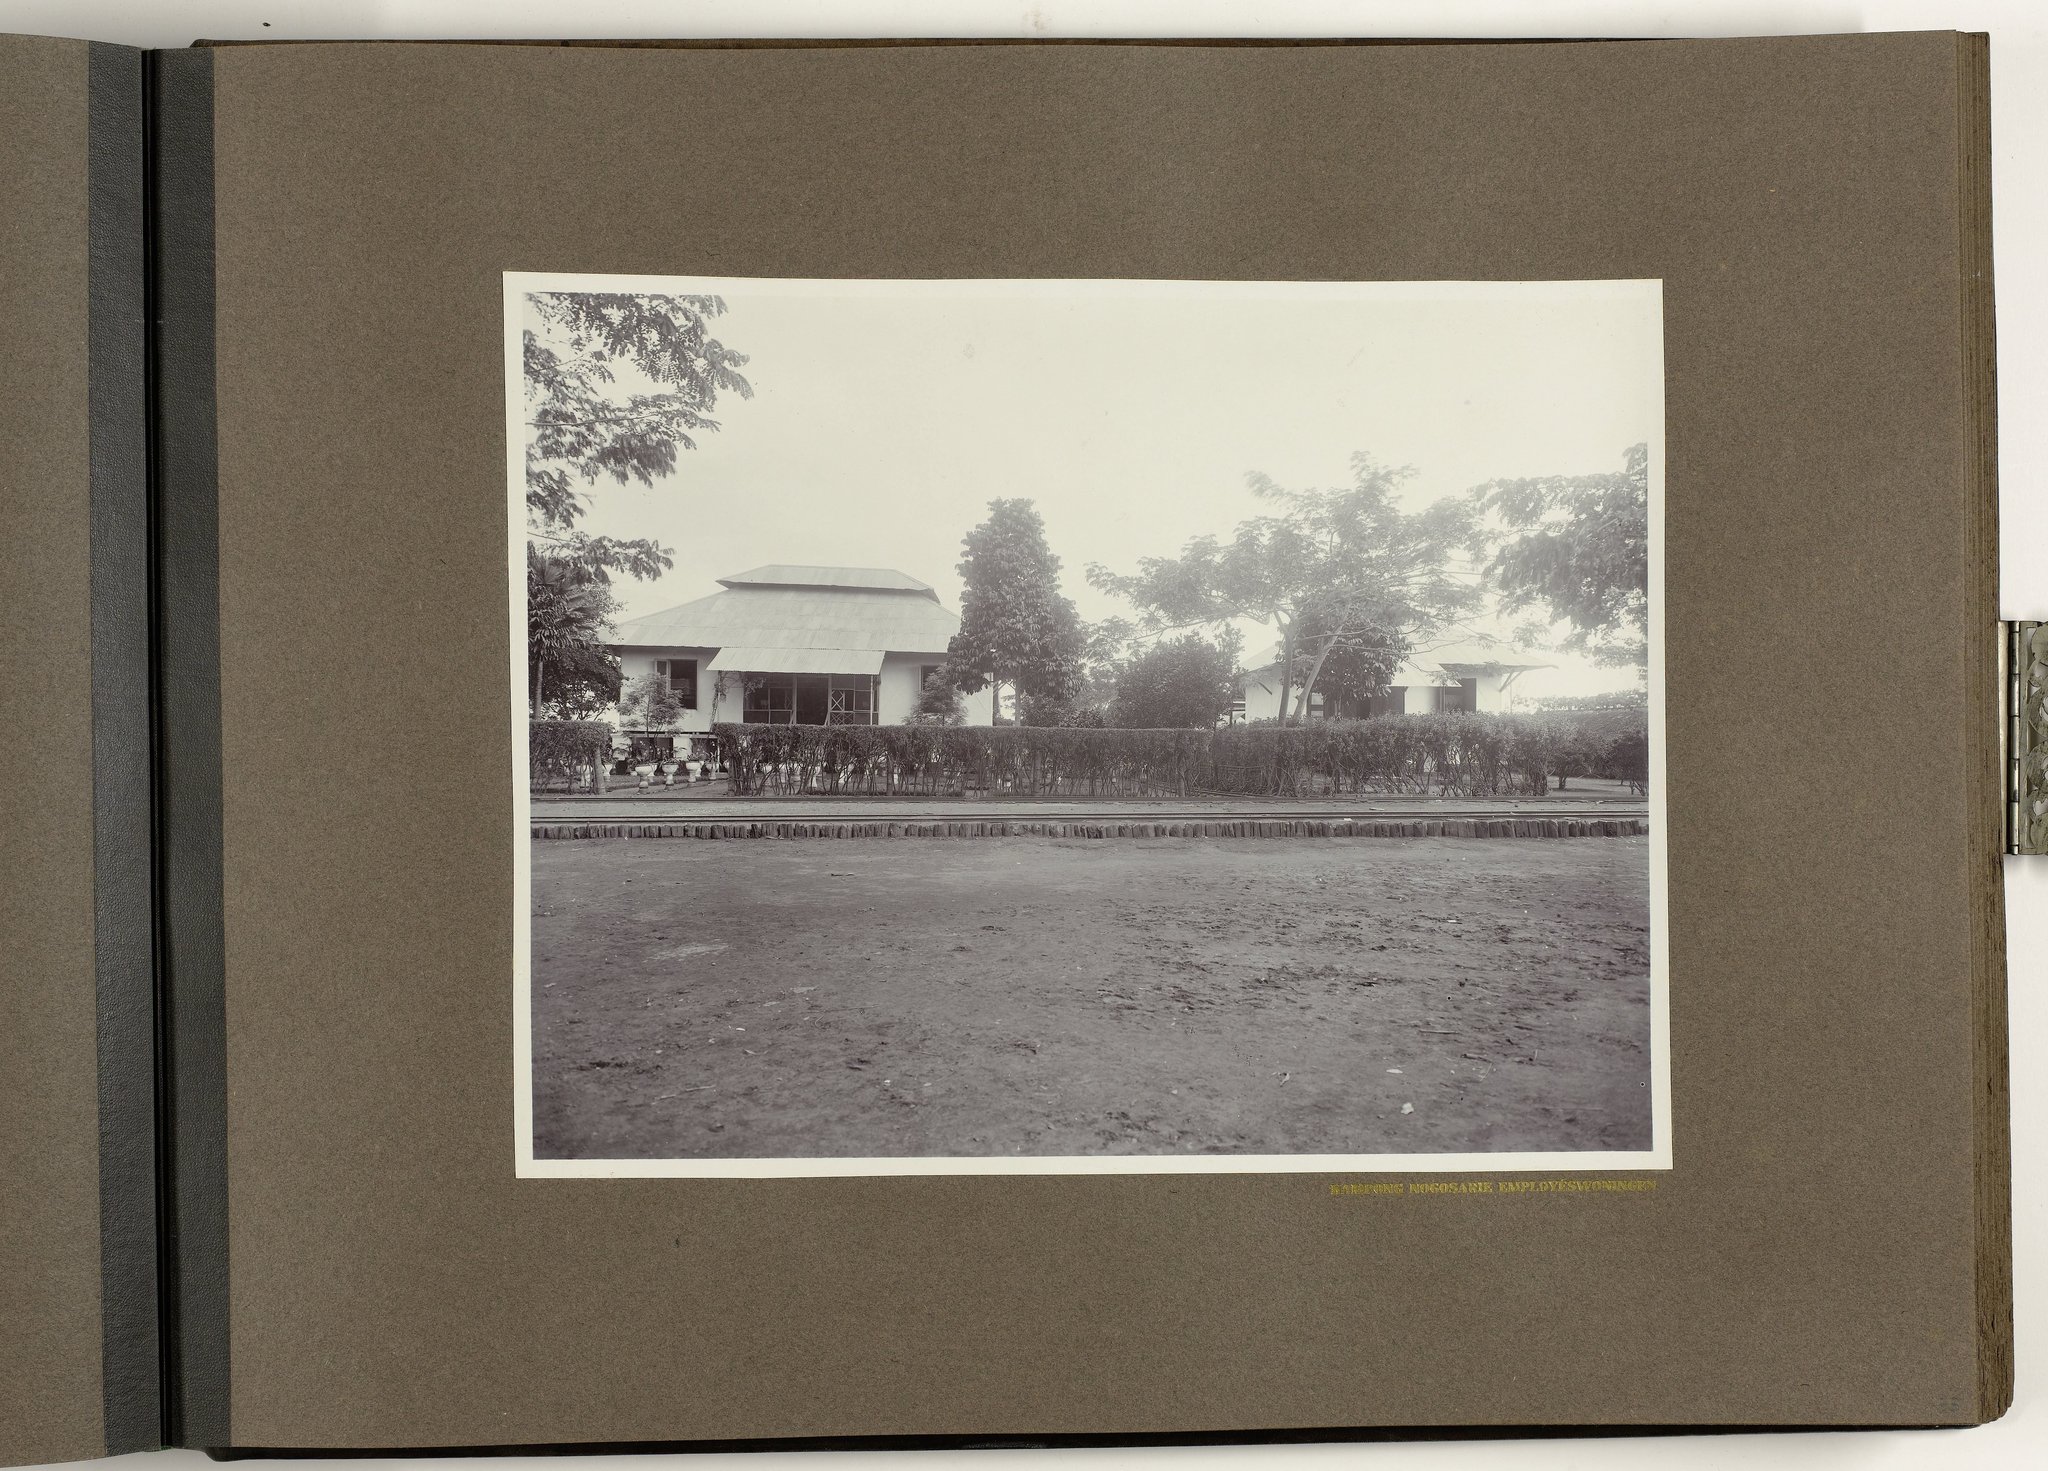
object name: photograph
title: Kampong Nogosarie employéswoningen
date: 1917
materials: photographic support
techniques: gelatin silver print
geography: jatiroto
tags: colonial system, (non-fruit) products of plants or trees: sugarcane, rural housing, e.g. country-house, villa, cottage, public road in village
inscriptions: inscription: ‘KAMPONG NOGOSARIE EMPLOYÉSWONINGEN’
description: Werknemerswoningen in het dorp Nogosarie. Witte huizen op palen, voor de huizen lopen een rails. Onderdeel van het fotoalbum aangeboden aan F.J. Wirix door het personeel van de Suikeronderneming Djatiroto in 1917.